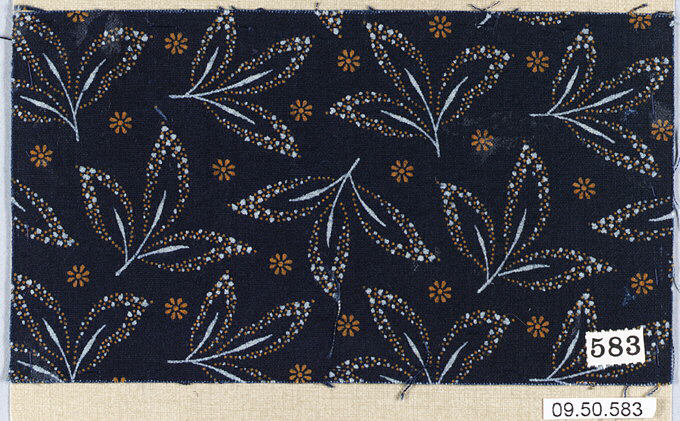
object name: piece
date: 1801-1900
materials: cotton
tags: leaves